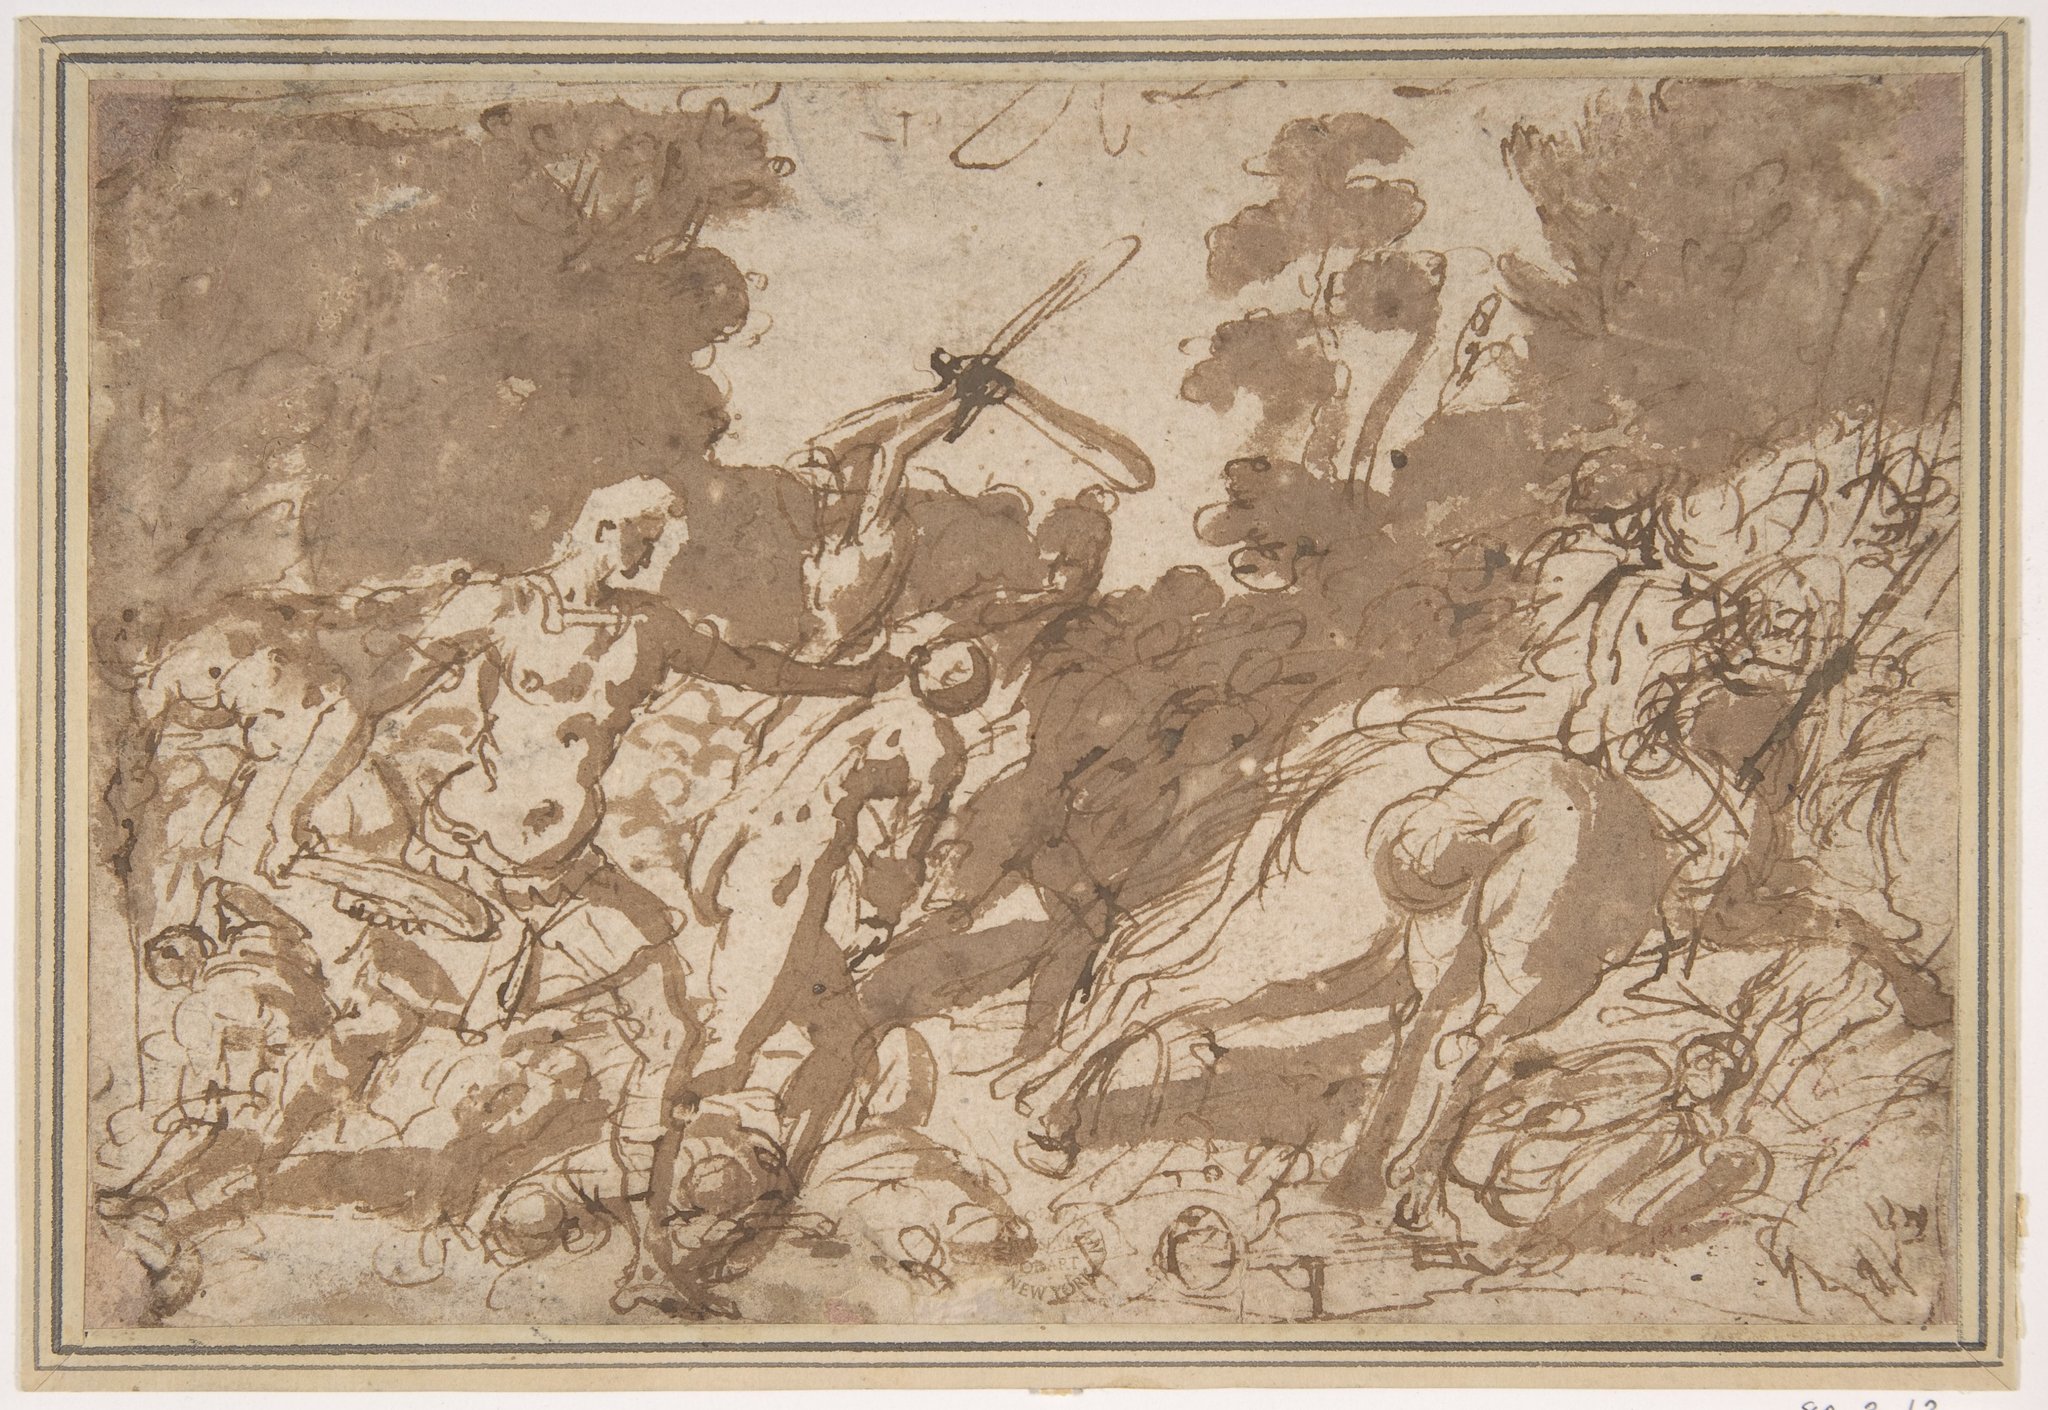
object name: drawing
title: Battle Scene (Samson Slaying the Philistines?)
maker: anonymous, italian, roman-bolognese, 17th century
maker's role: artist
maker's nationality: italian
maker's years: 1600-1700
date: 1601-1700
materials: ink, paper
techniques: brush, pen, wash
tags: battles,swords,men